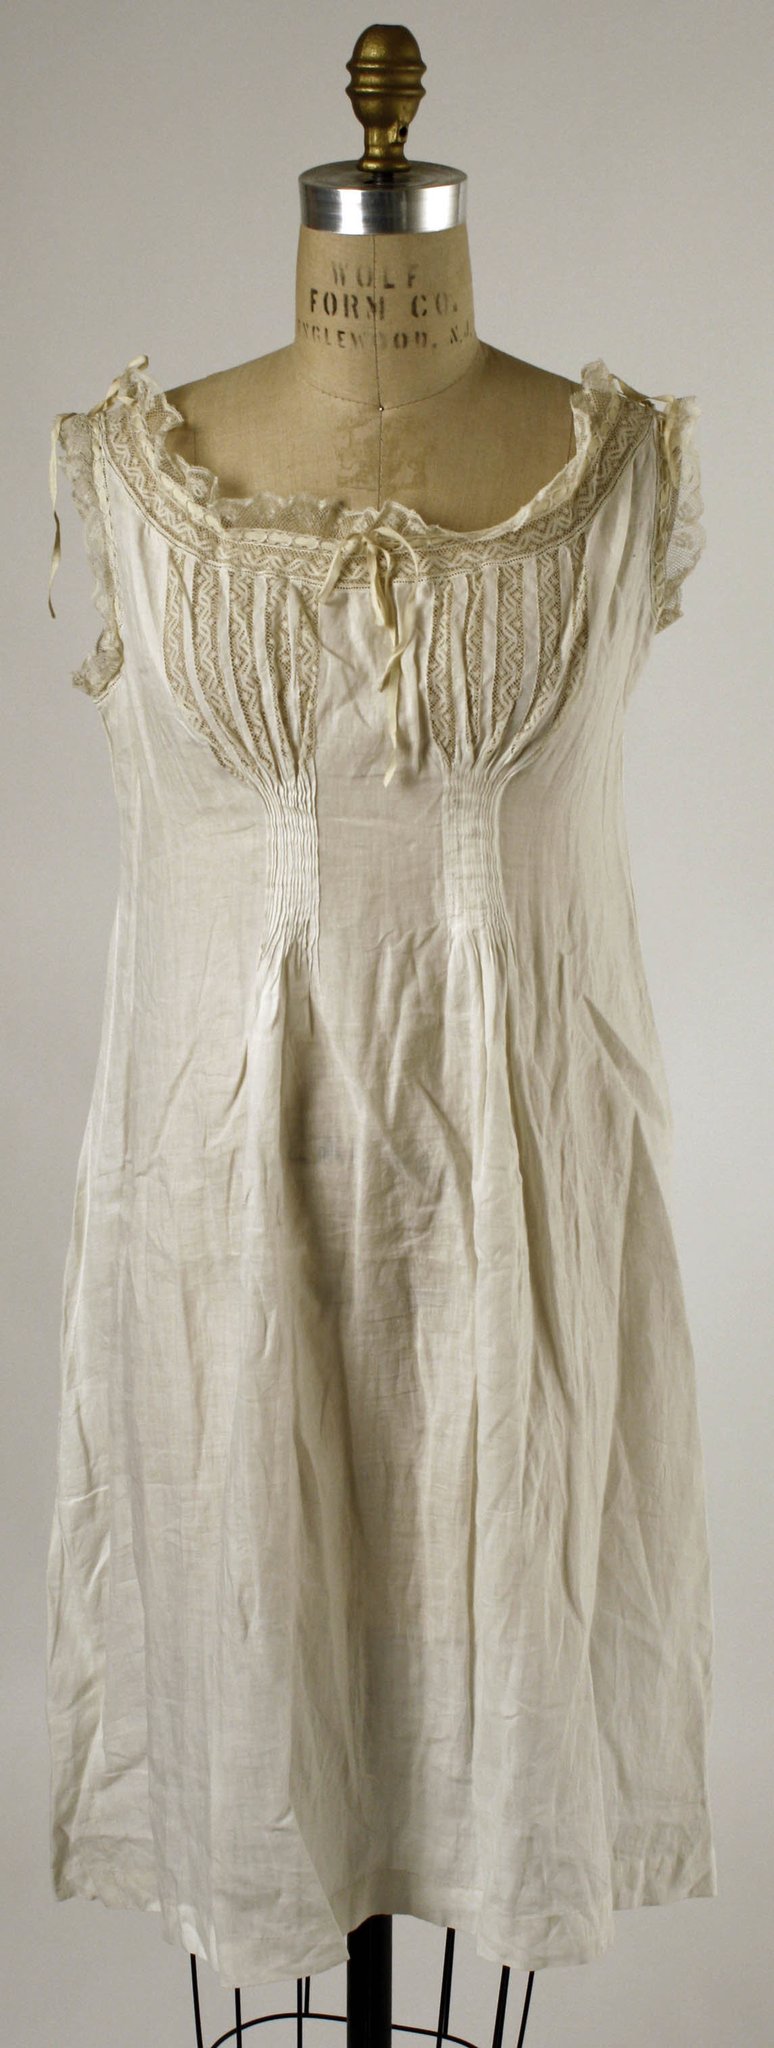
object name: chemise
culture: american or european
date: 1887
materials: cotton